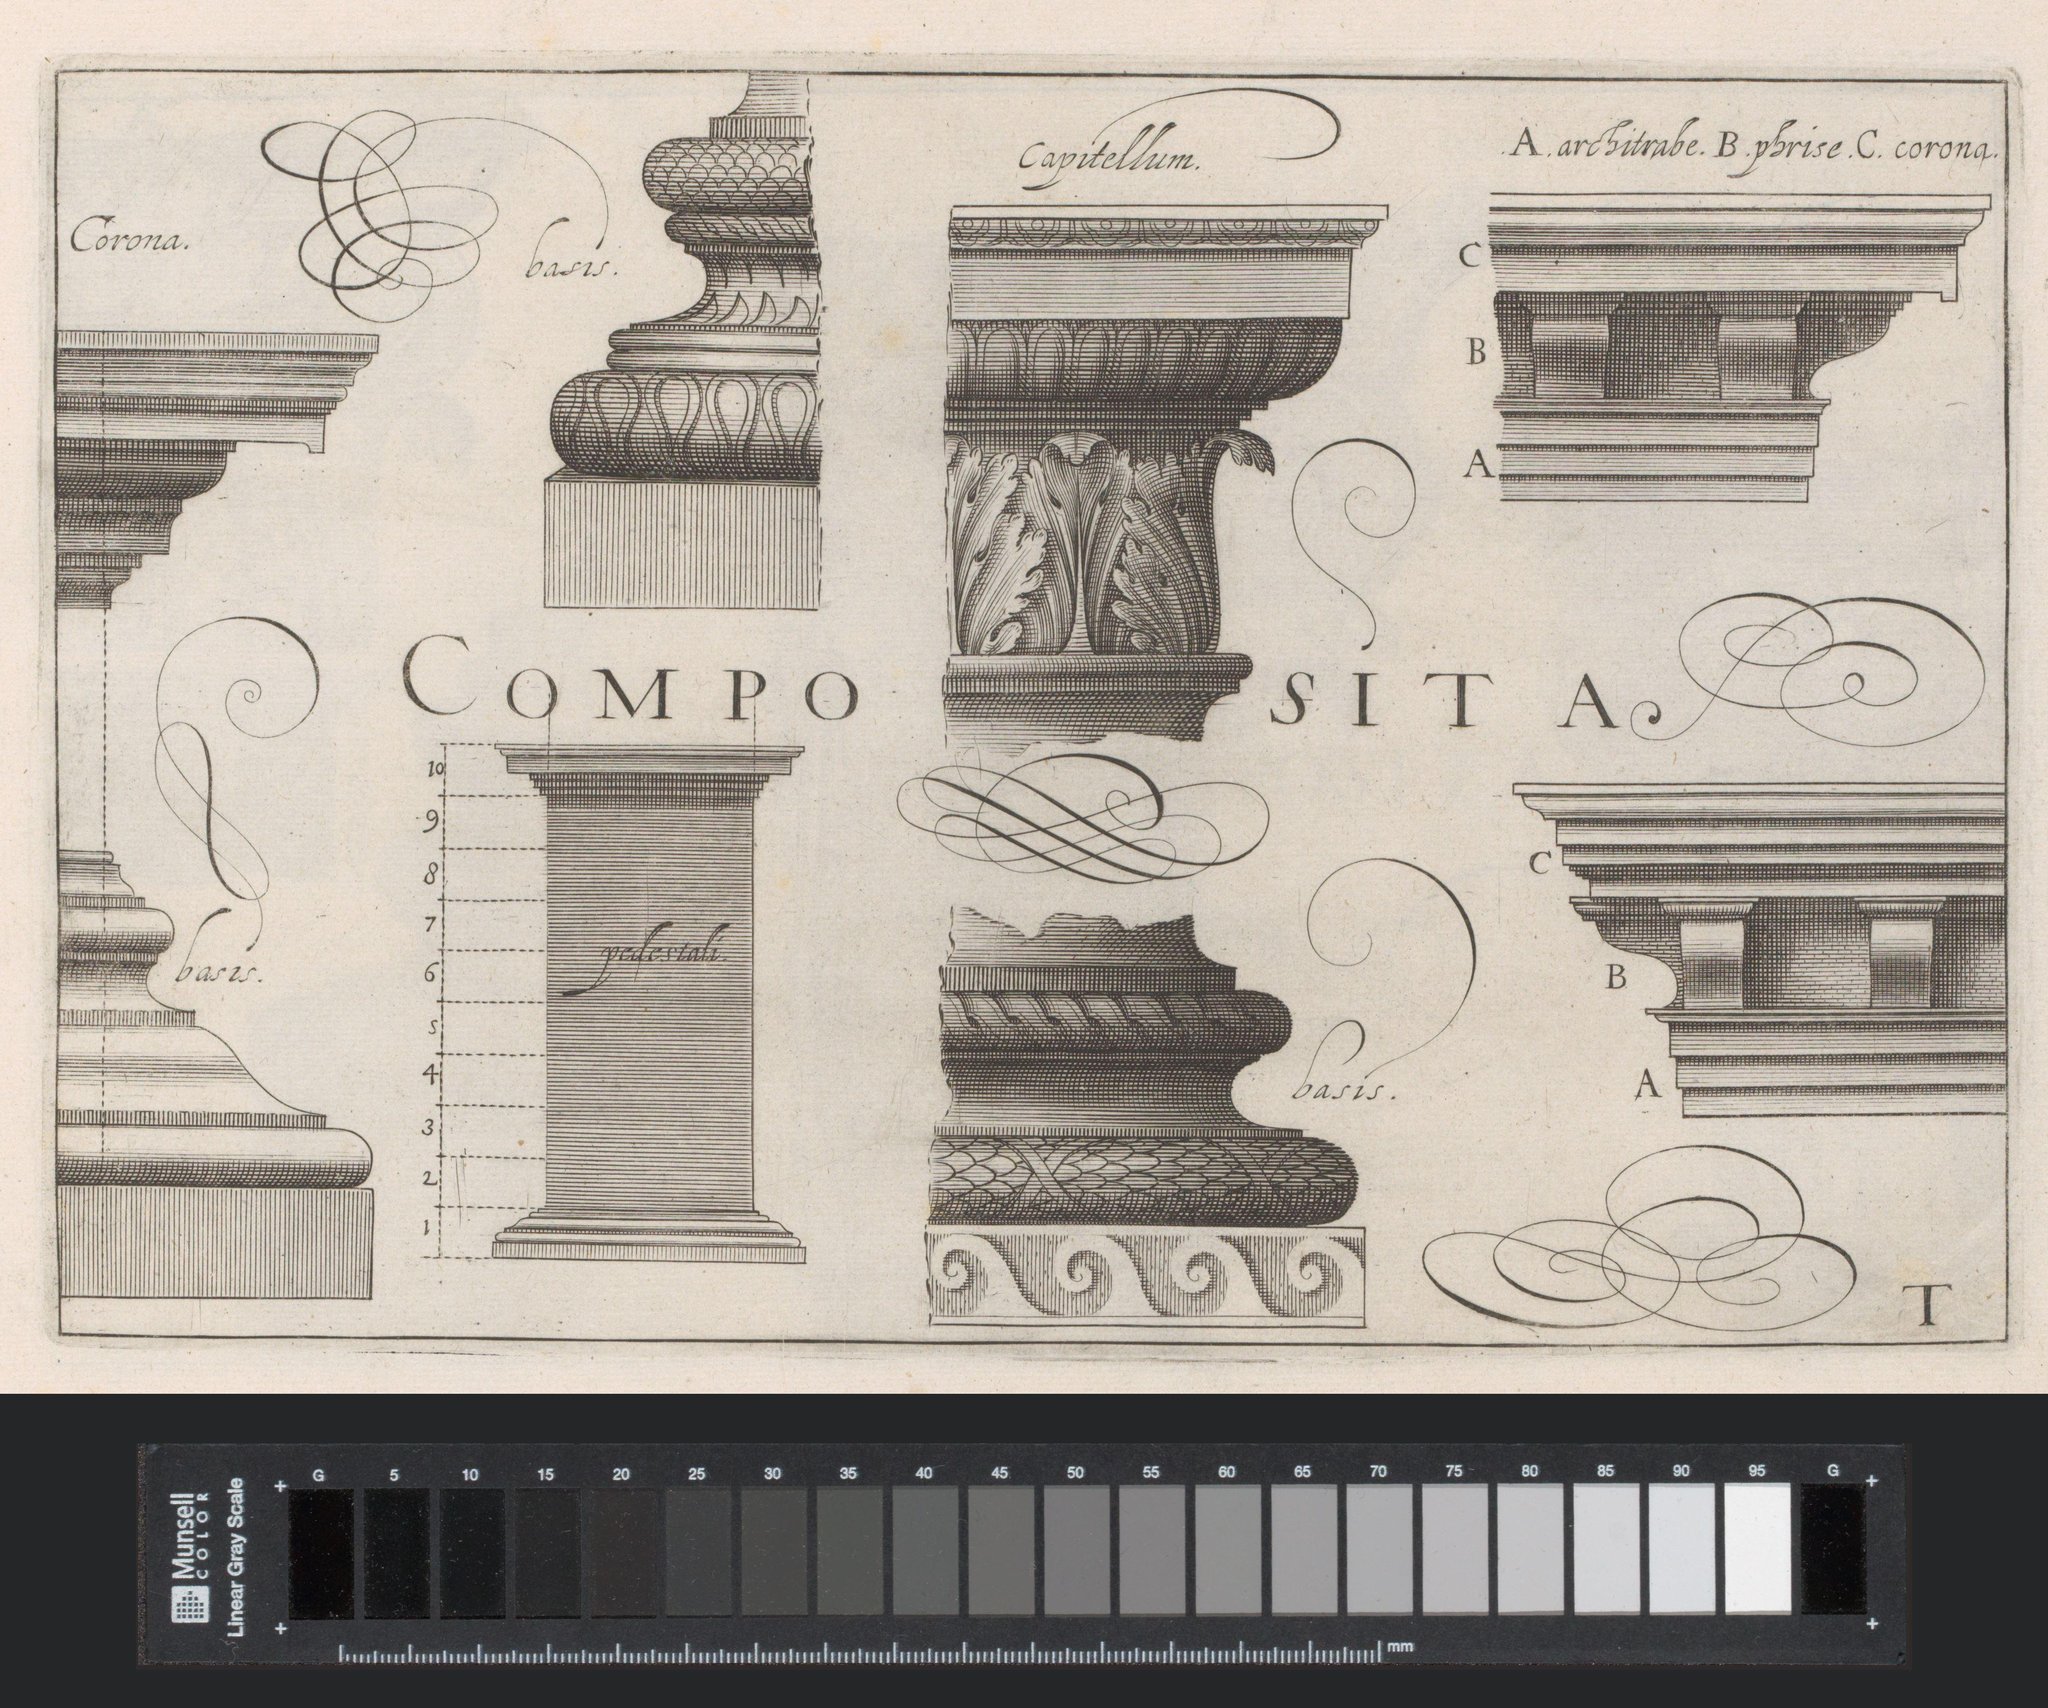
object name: print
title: Architectura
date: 1606-1607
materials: paper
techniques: engraving, etching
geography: the hague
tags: composite order ~ architecture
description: Details van de Composiete bouworde: kroonlijst, basement, piëdestal, hoofdgestel en zuil. Rechtsonder: T. Prent maakt deel uit van een album.